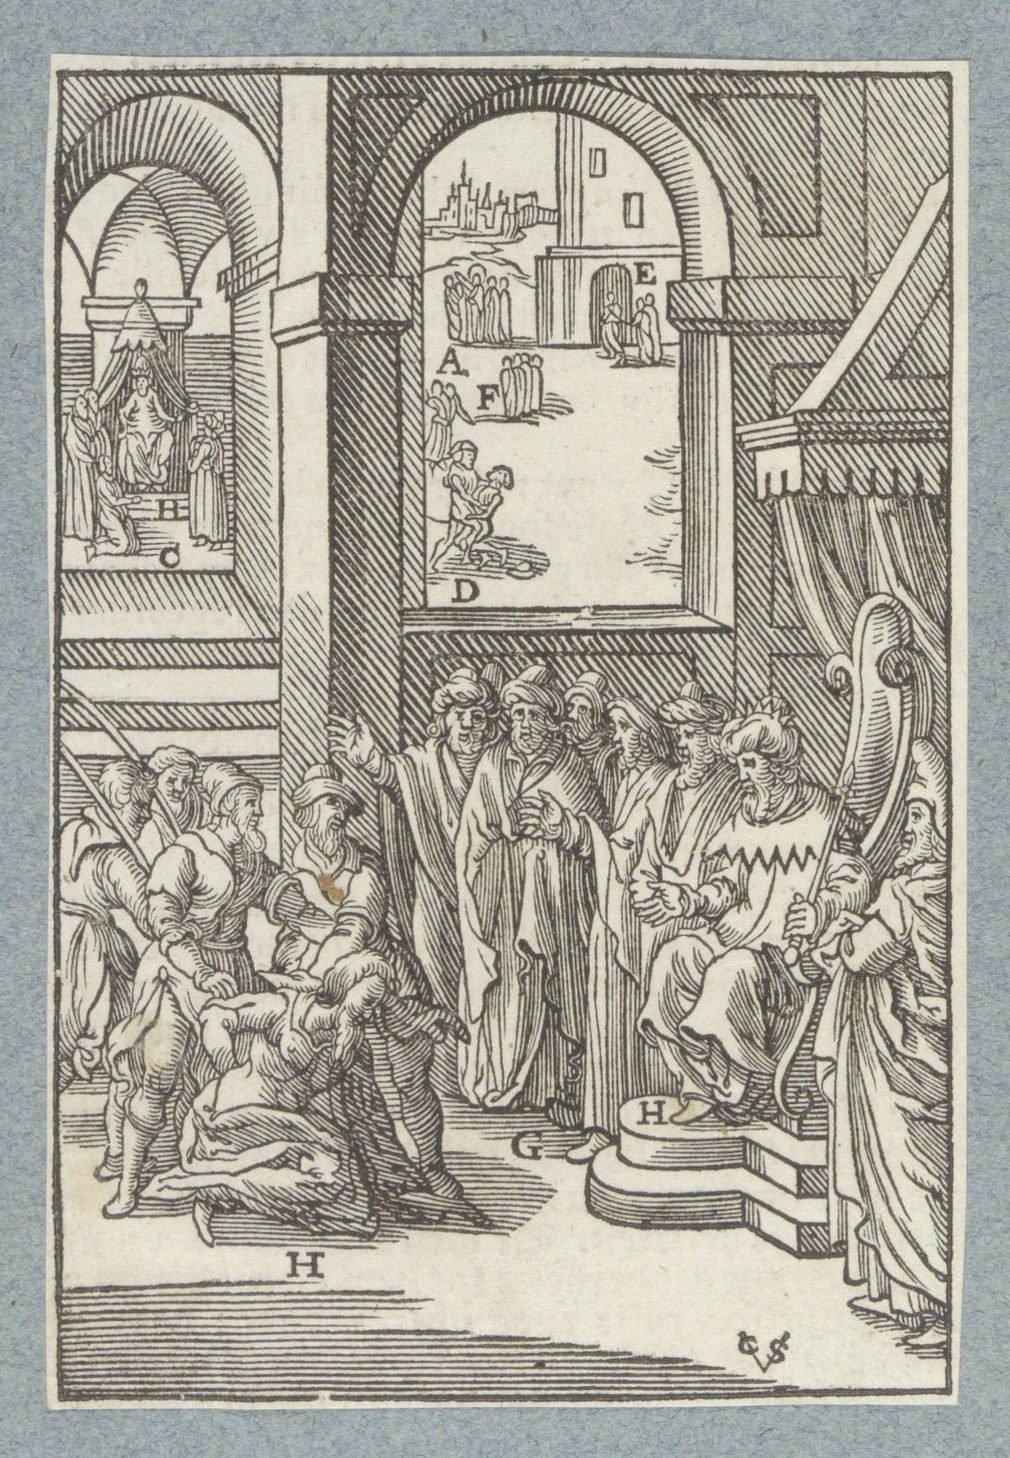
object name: book illustration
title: Gelijkenis van de ondankbare dienstknecht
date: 1629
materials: paper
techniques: letterpress printing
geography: amsterdam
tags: the unmerciful servant: the king forgives him his debts ~ parable of christ (matthew 18:23-35), the unmerciful servant attacks his fellow-servant who owes him money, and casts him into prison ~ parable of the unmerciful servant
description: De ondankbare dienstknecht knielt voor de koning en smeekt hem om hem meer tijd te geven om zijn schuld terug te betalen. De koning kreeg medelijden, liet hem vrij en schold hem het geleende geld kwijt. De ondankbare knecht valt vervolgens een van zijn schuldenaars aan en brengt hem naar de gevangenis. Bij verschillende elementen uit de voorstelling staan letters. De prent maakt deel uit van een album.